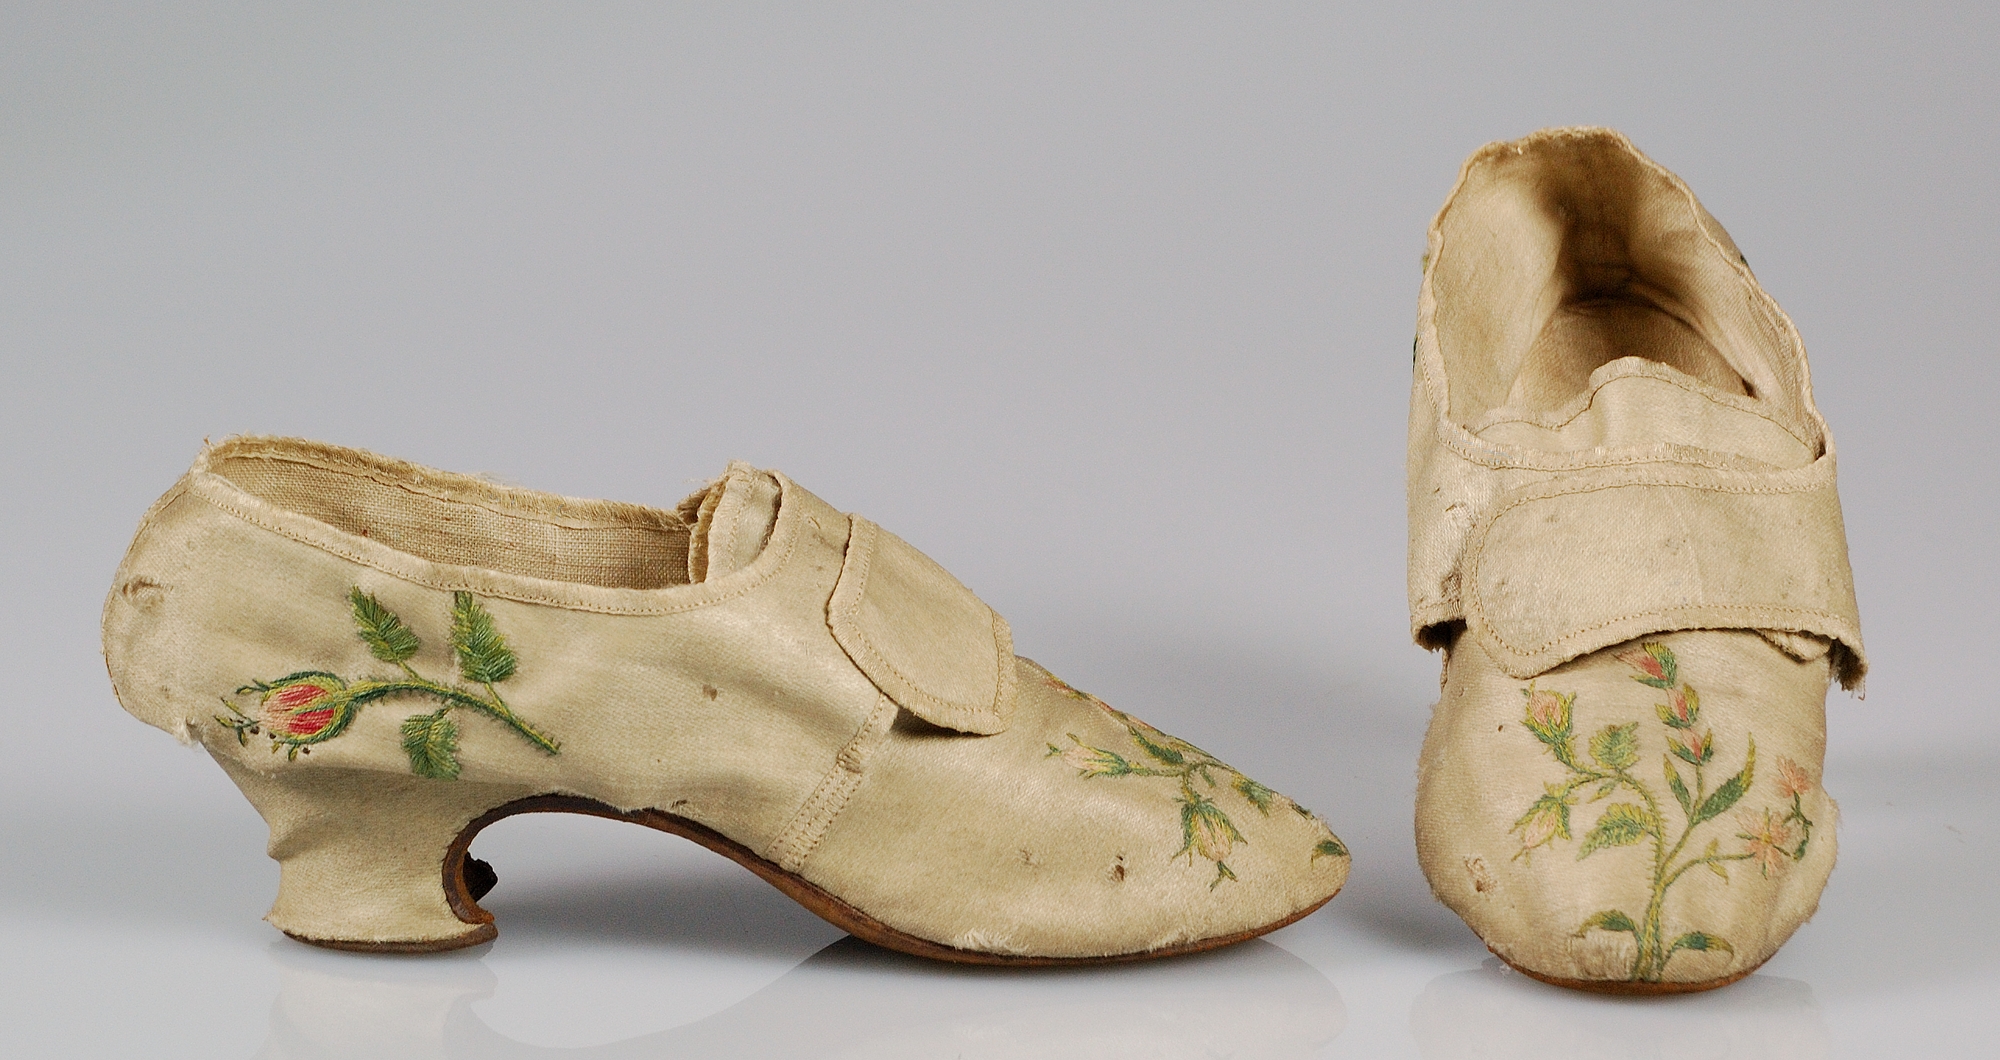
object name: shoe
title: Shoes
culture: british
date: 1740-1760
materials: wool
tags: plants